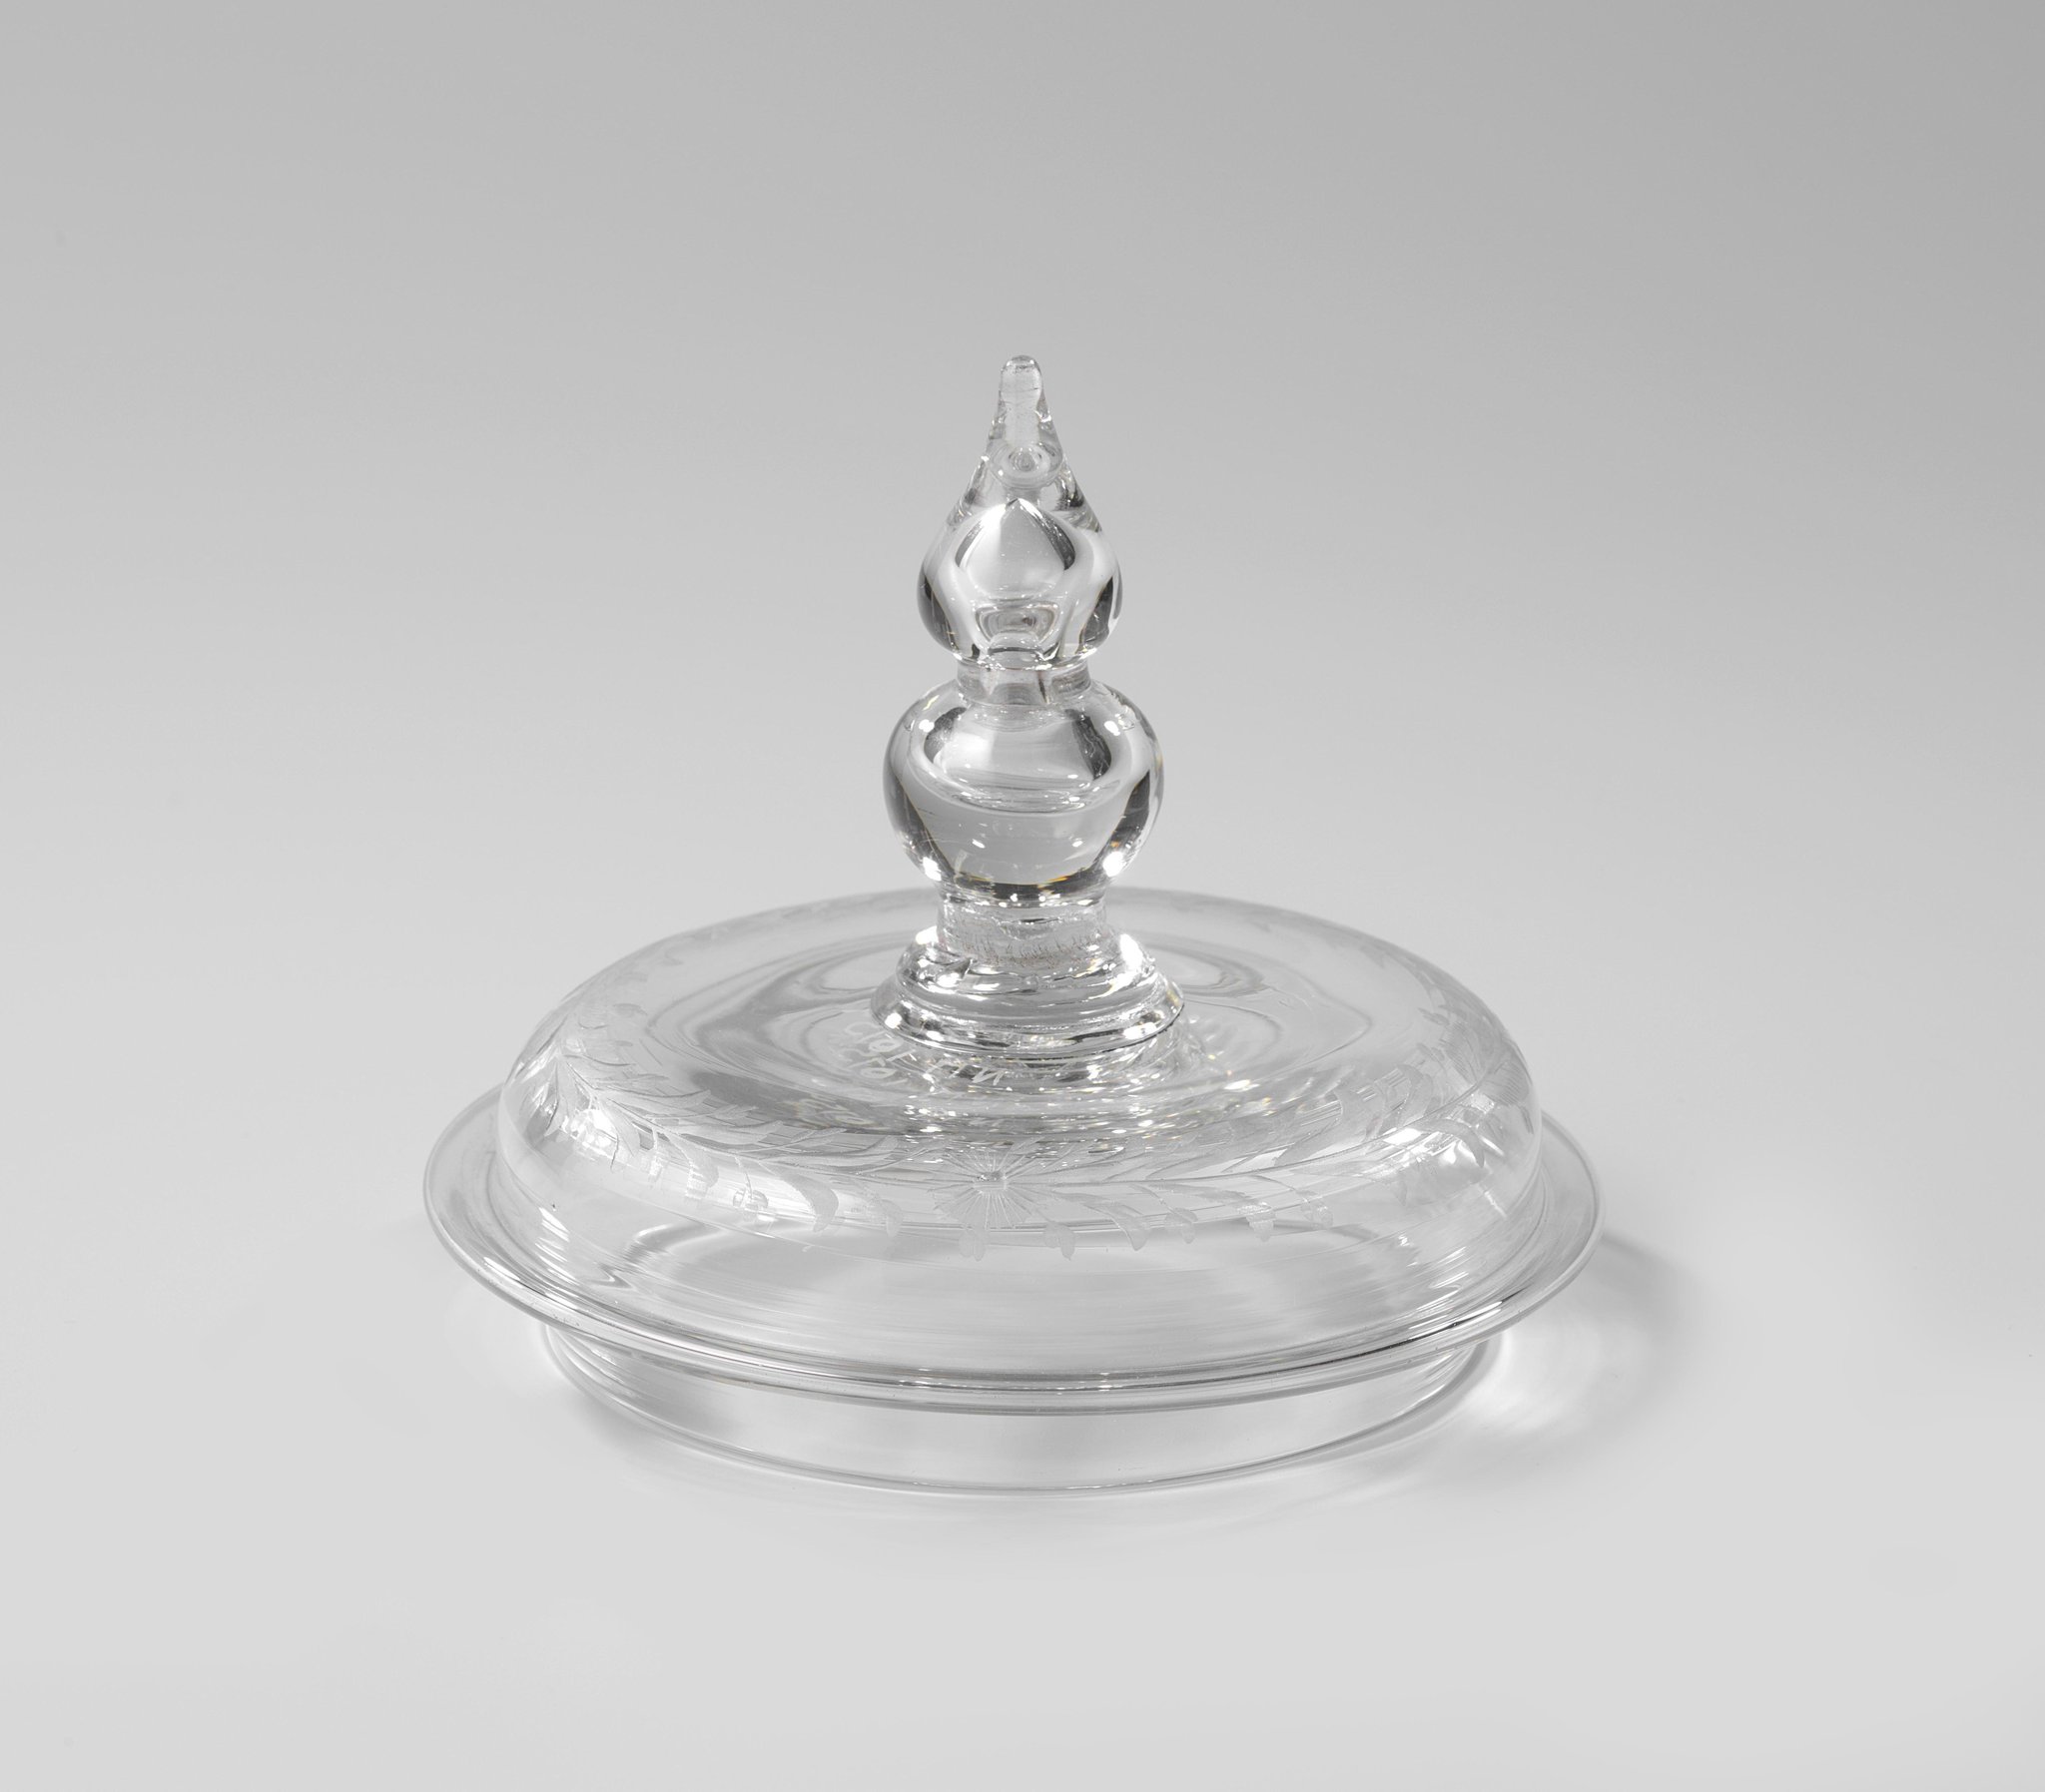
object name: lid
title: Deksel van een bokaal met bladkrans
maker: Anonymous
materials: glass